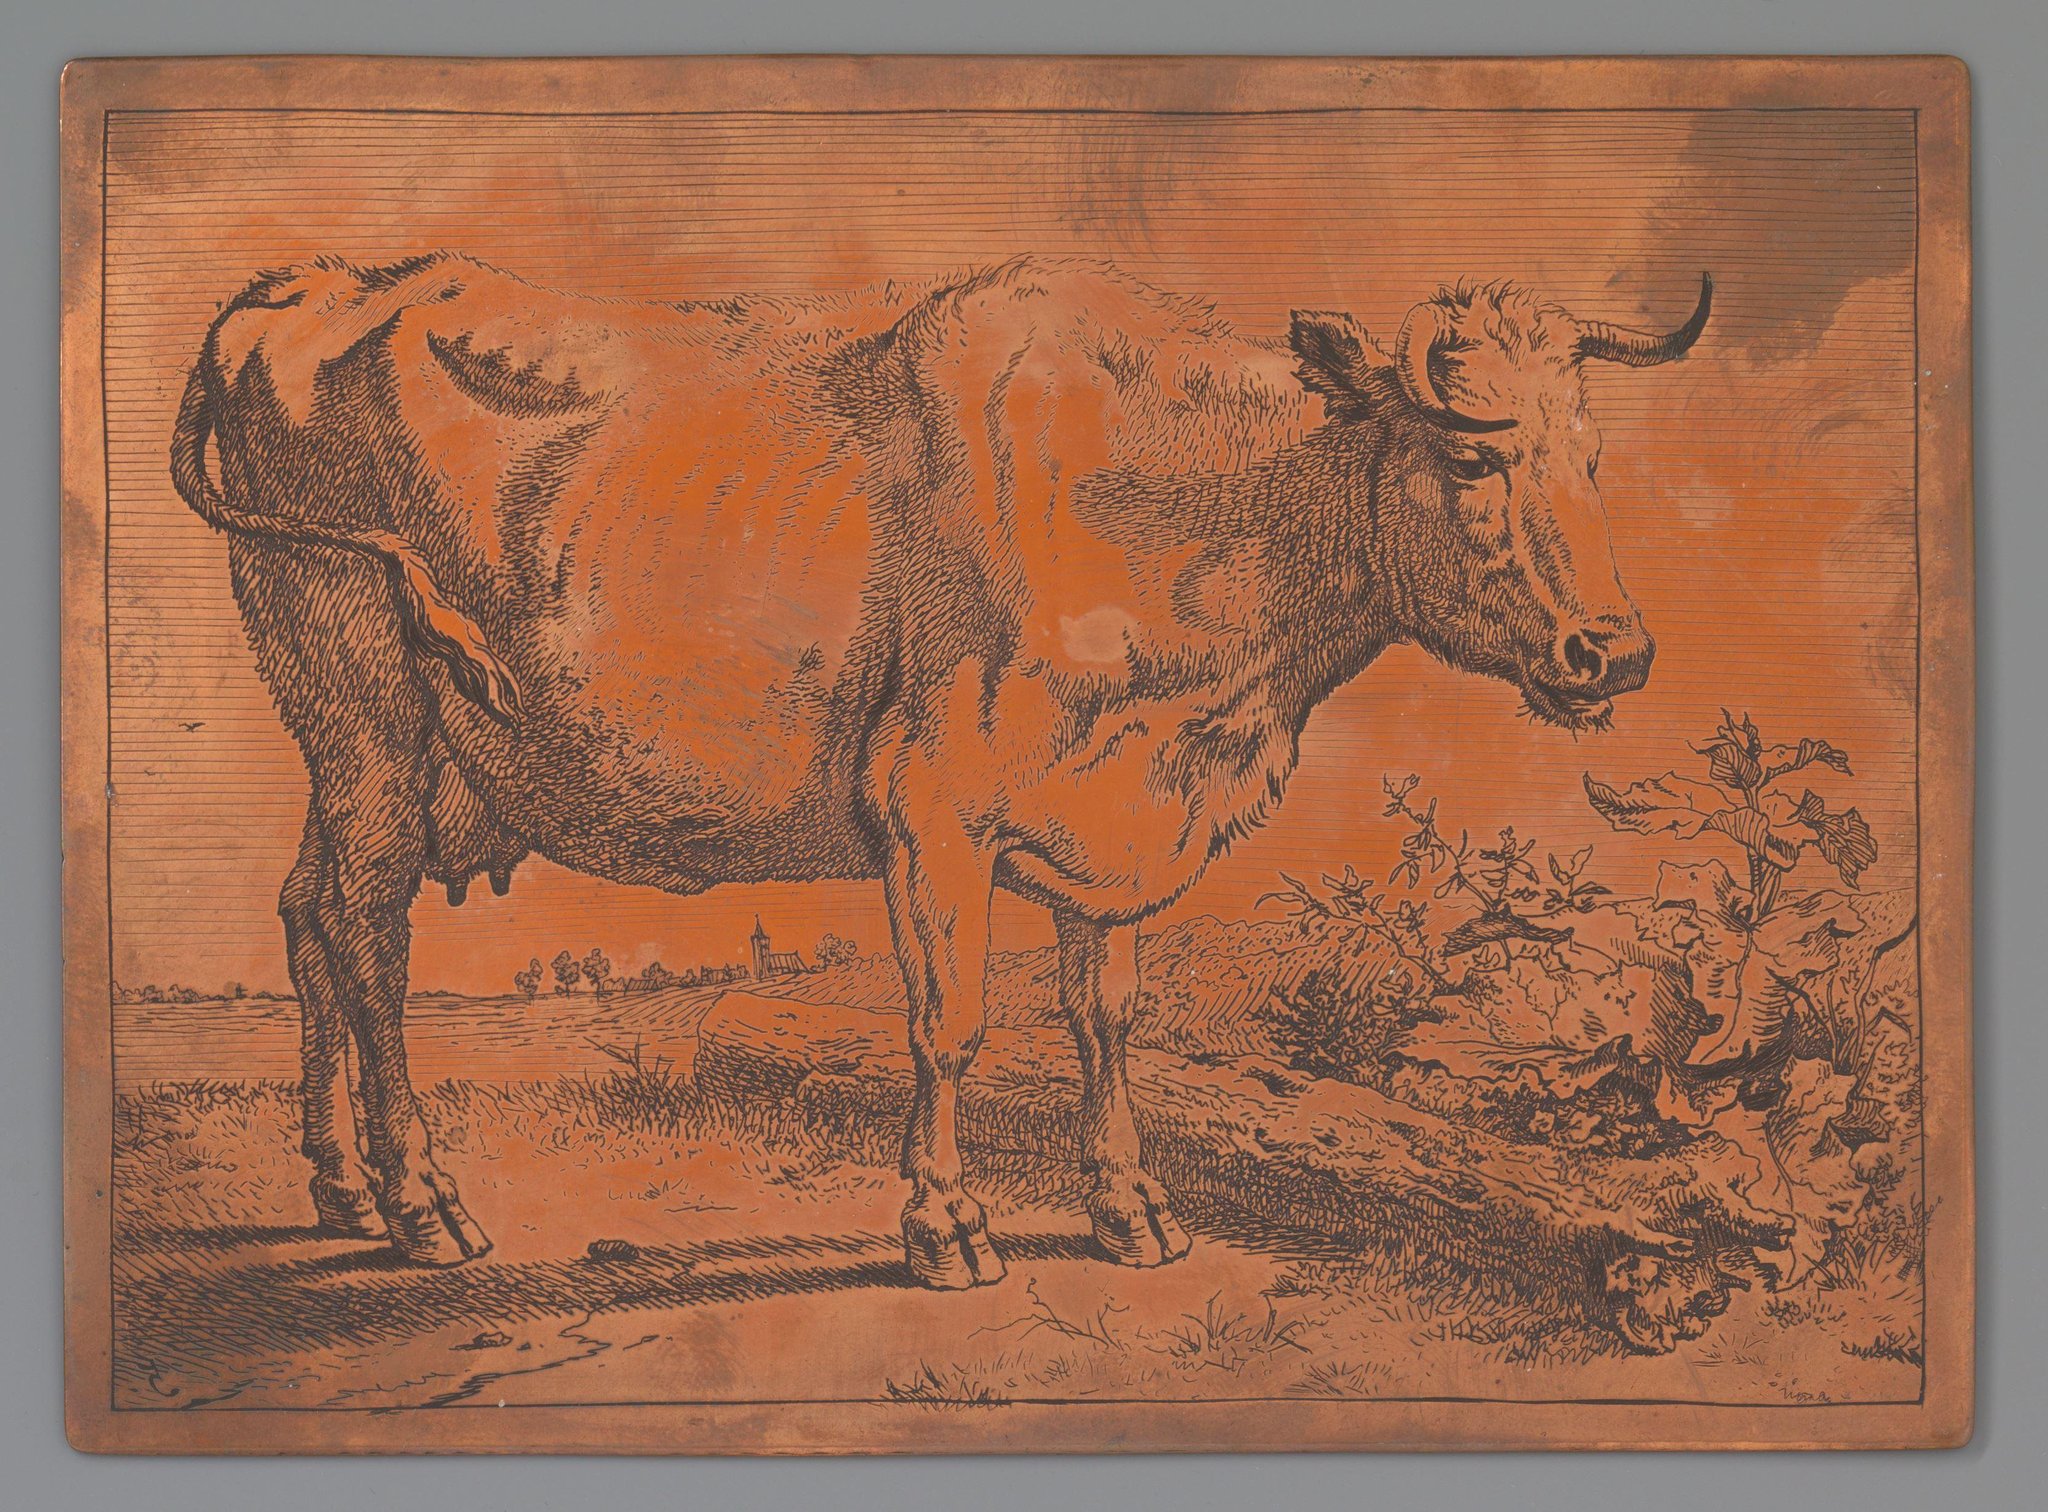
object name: copper plate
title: Het Bullenboekje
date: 1650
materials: copper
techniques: etching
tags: cow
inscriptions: inscription: ‘1700 / [...] / [...]’